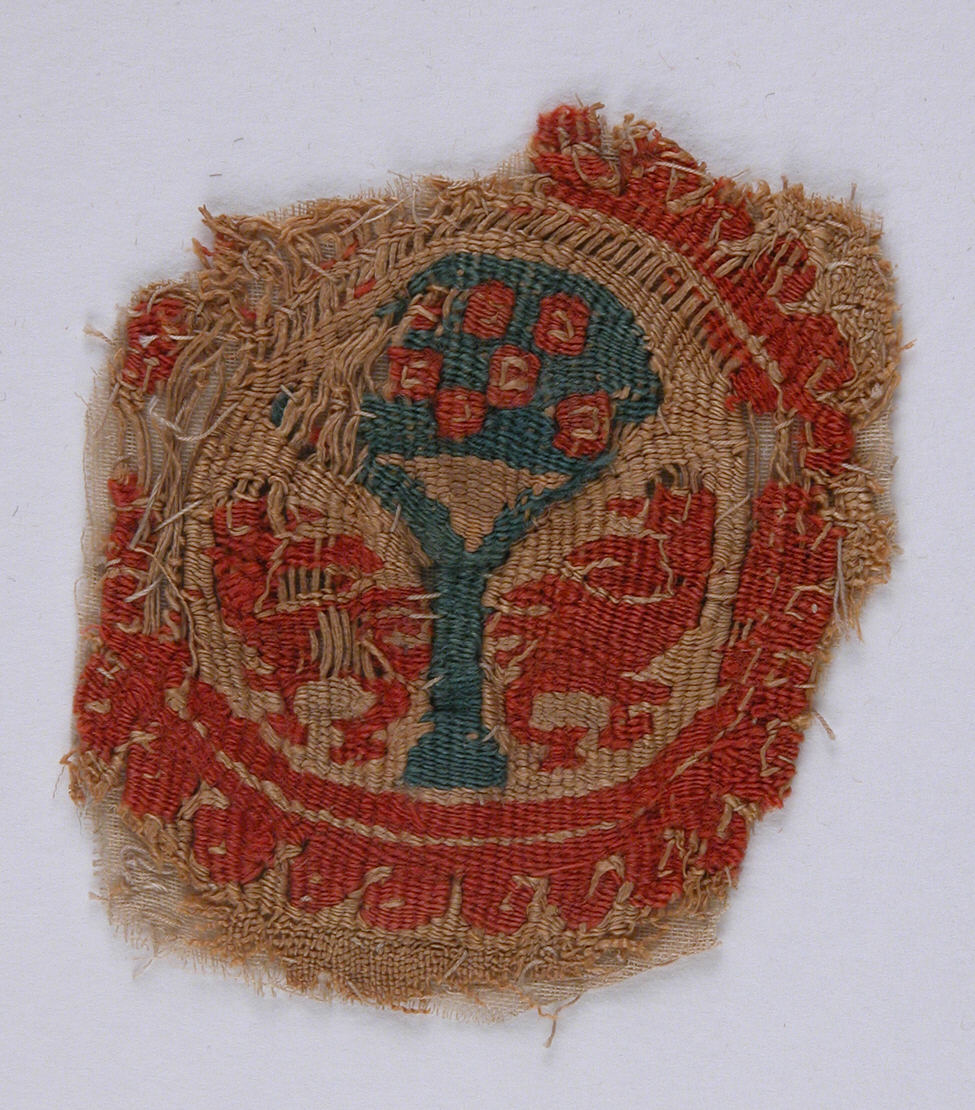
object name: textile fragment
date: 501-700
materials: linen, wool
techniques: weave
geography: egypt